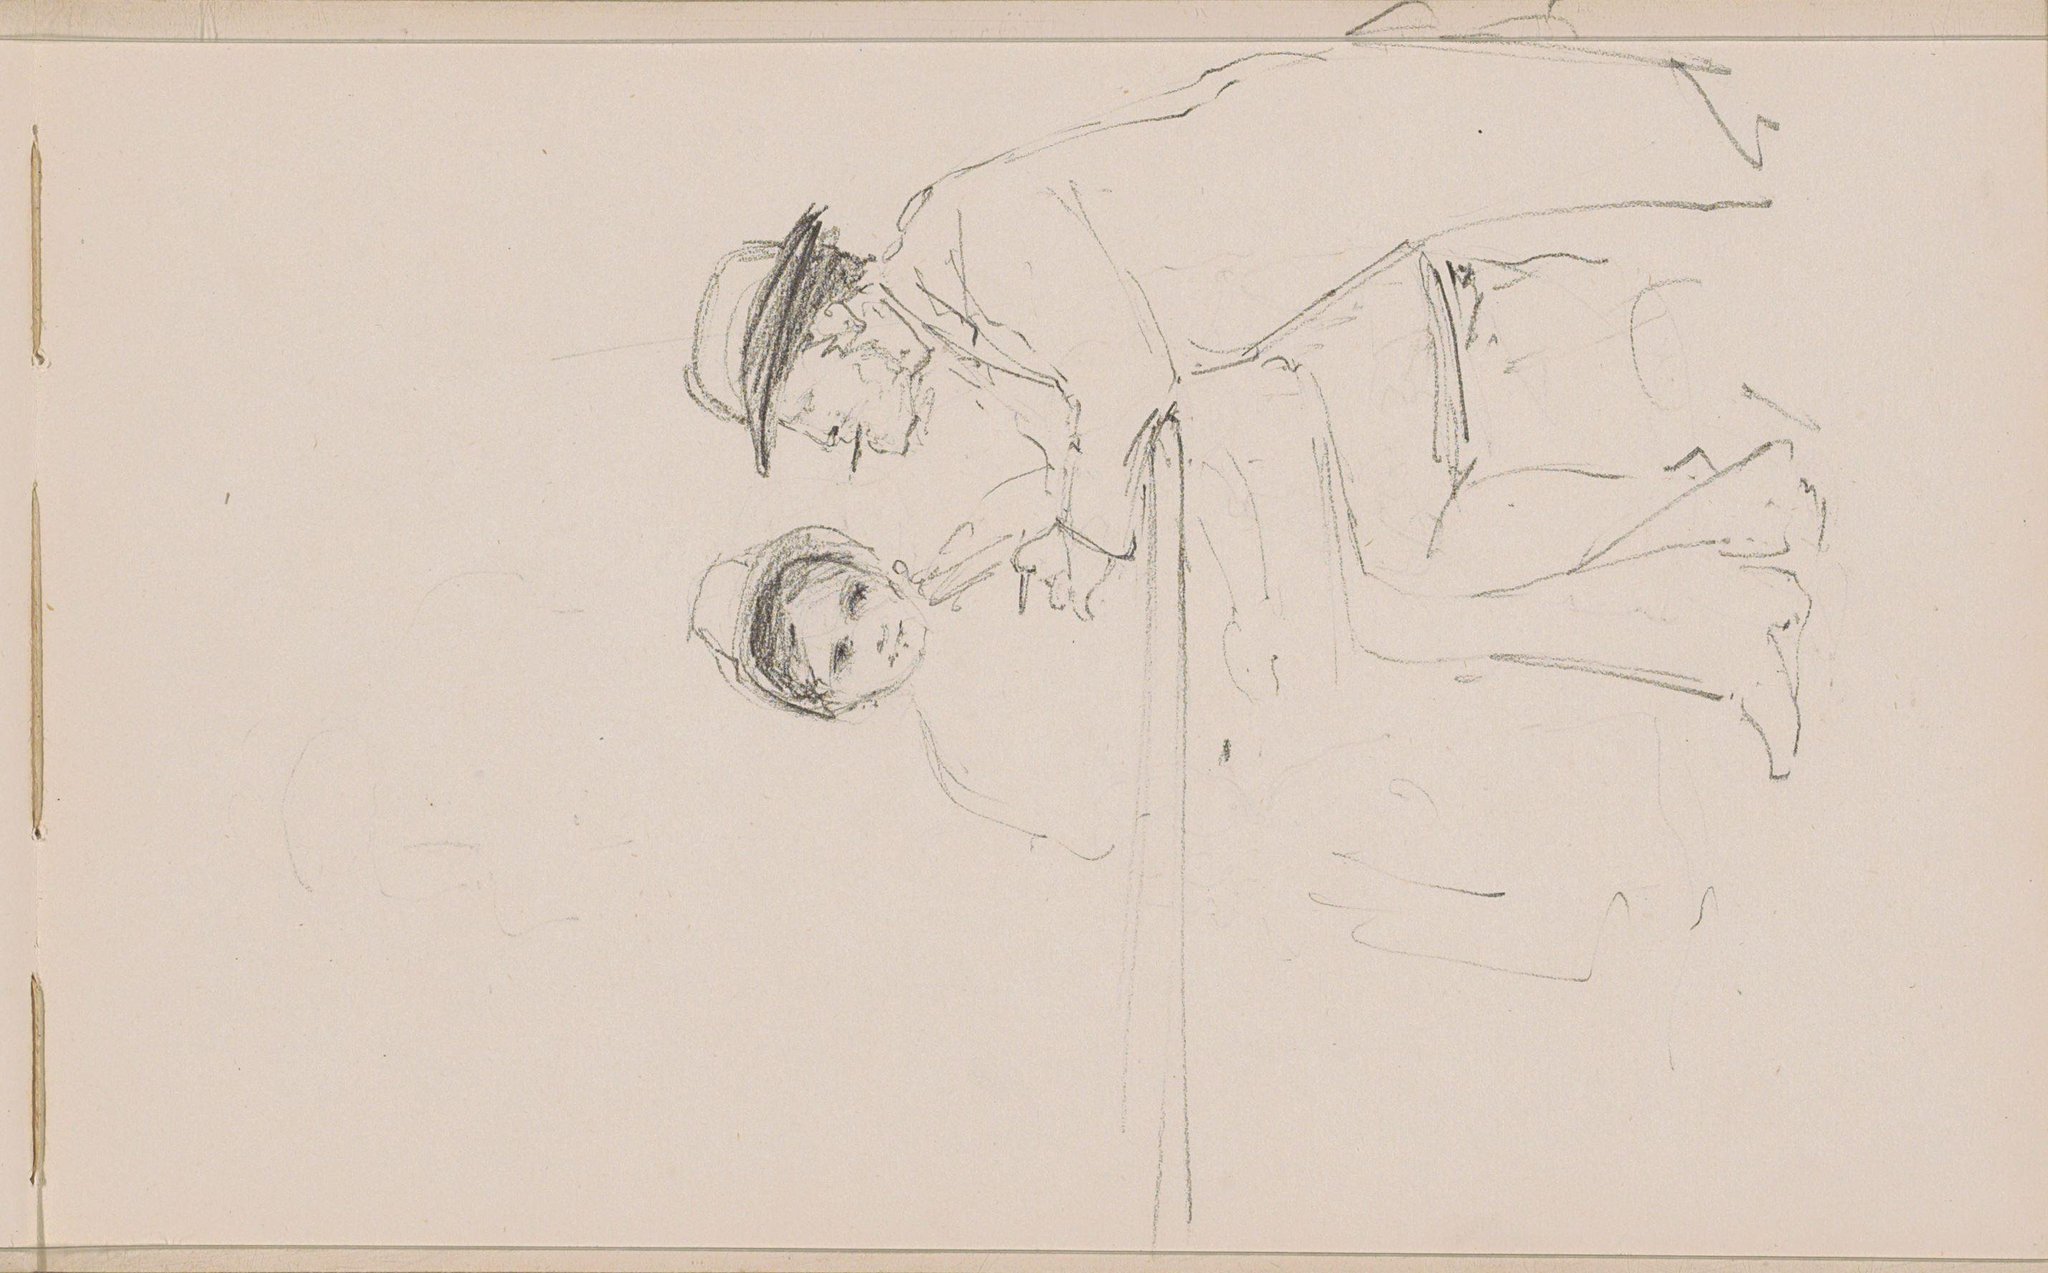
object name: sketchbook leaf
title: Vrouw en een rokende man met een pen in de hand aan een tafel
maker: a.a.l. de grammont-hubrecht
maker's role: draughtsman, painter, print maker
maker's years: 1855-1913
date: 1865-1913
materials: chalk, paper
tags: sitting figure, adult woman, adult man, pipe ~ tobacco, pen, table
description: Blad 15 recto uit een schetsboek met 28 bladen.